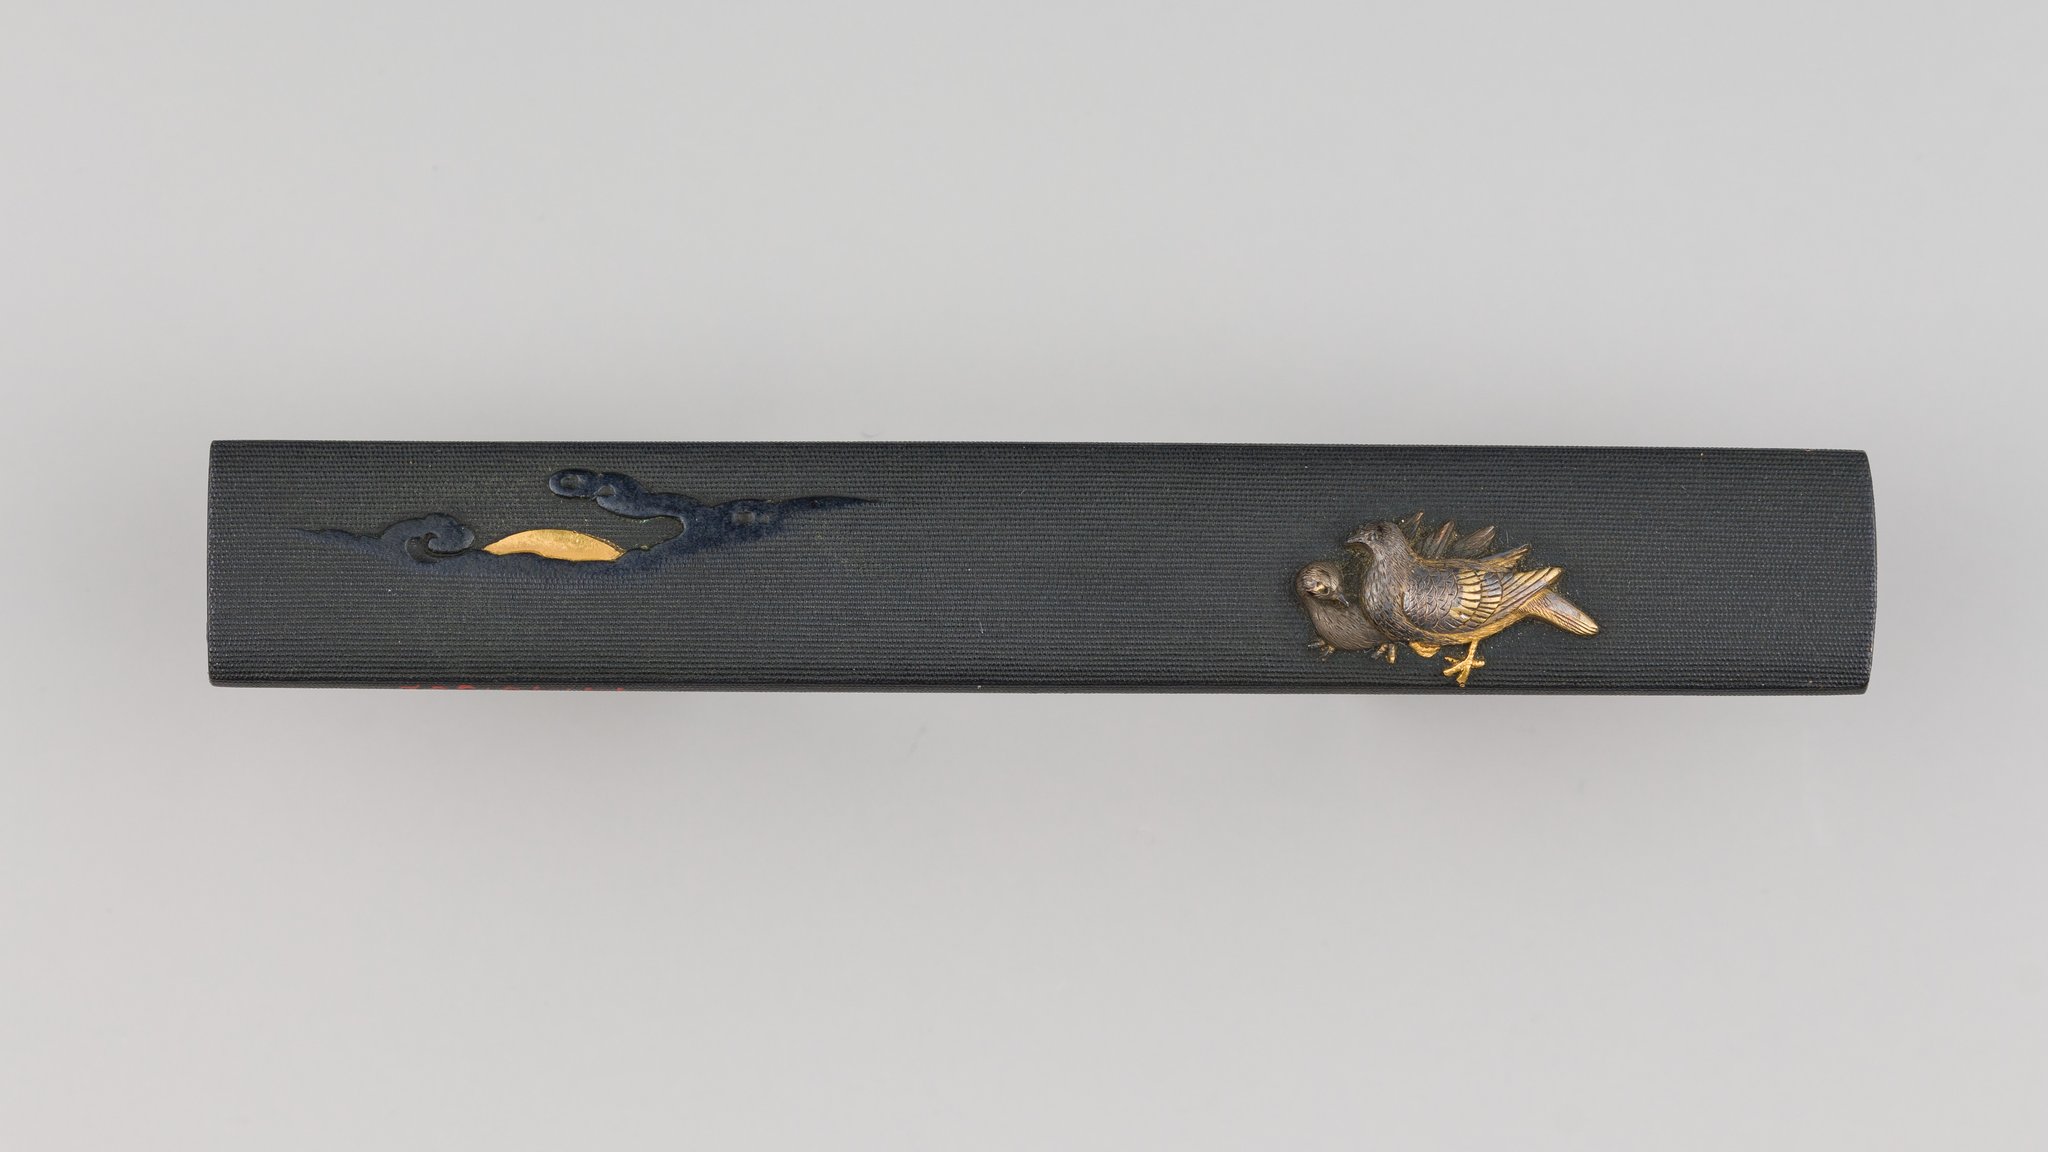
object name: knife handle kozuka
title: Knife Handle (Kozuka)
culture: japanese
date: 1801-1900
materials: gold alloy, gold, silver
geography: japan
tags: birds